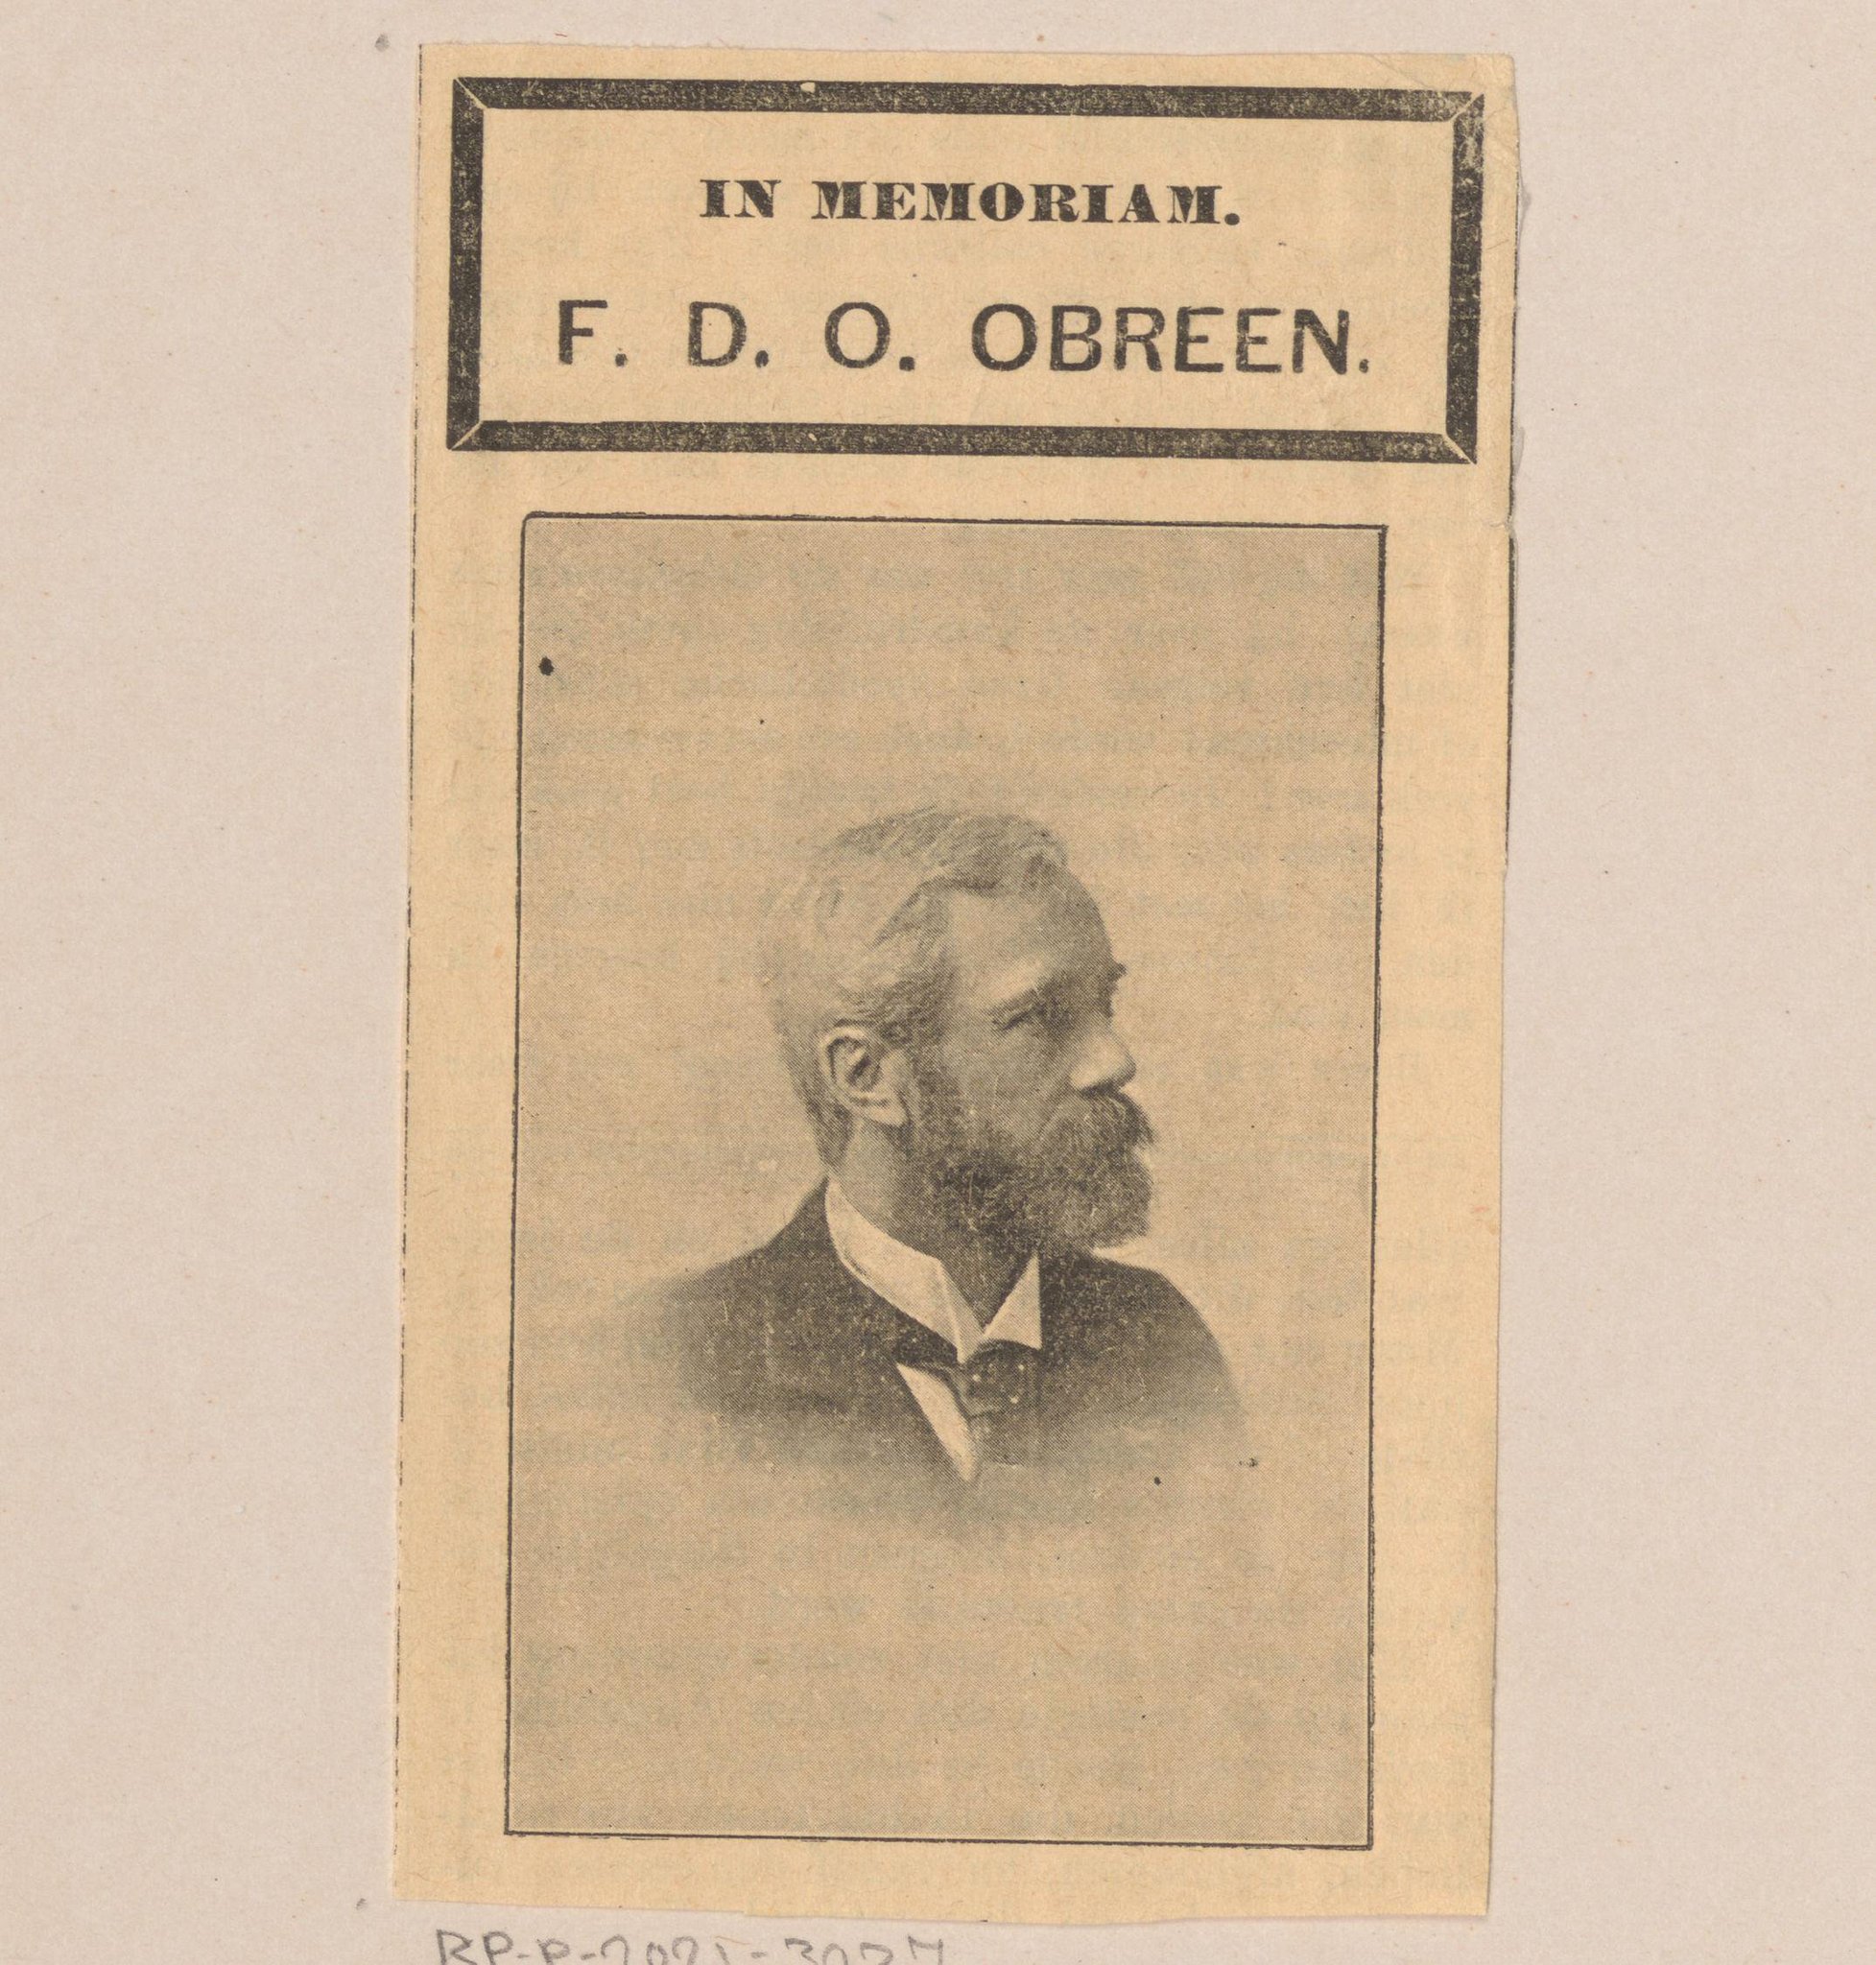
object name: photomechanical print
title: Portret van Frederik Daniel Otto Obreen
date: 1896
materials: paper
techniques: letterpress printing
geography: amsterdam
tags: rotterdam, amsterdam, draughtsman, frederik daniel otto obreen, historical persons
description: Prent uit: De Amsterdammer: weekblad voor Nederland, 8 november 1896.